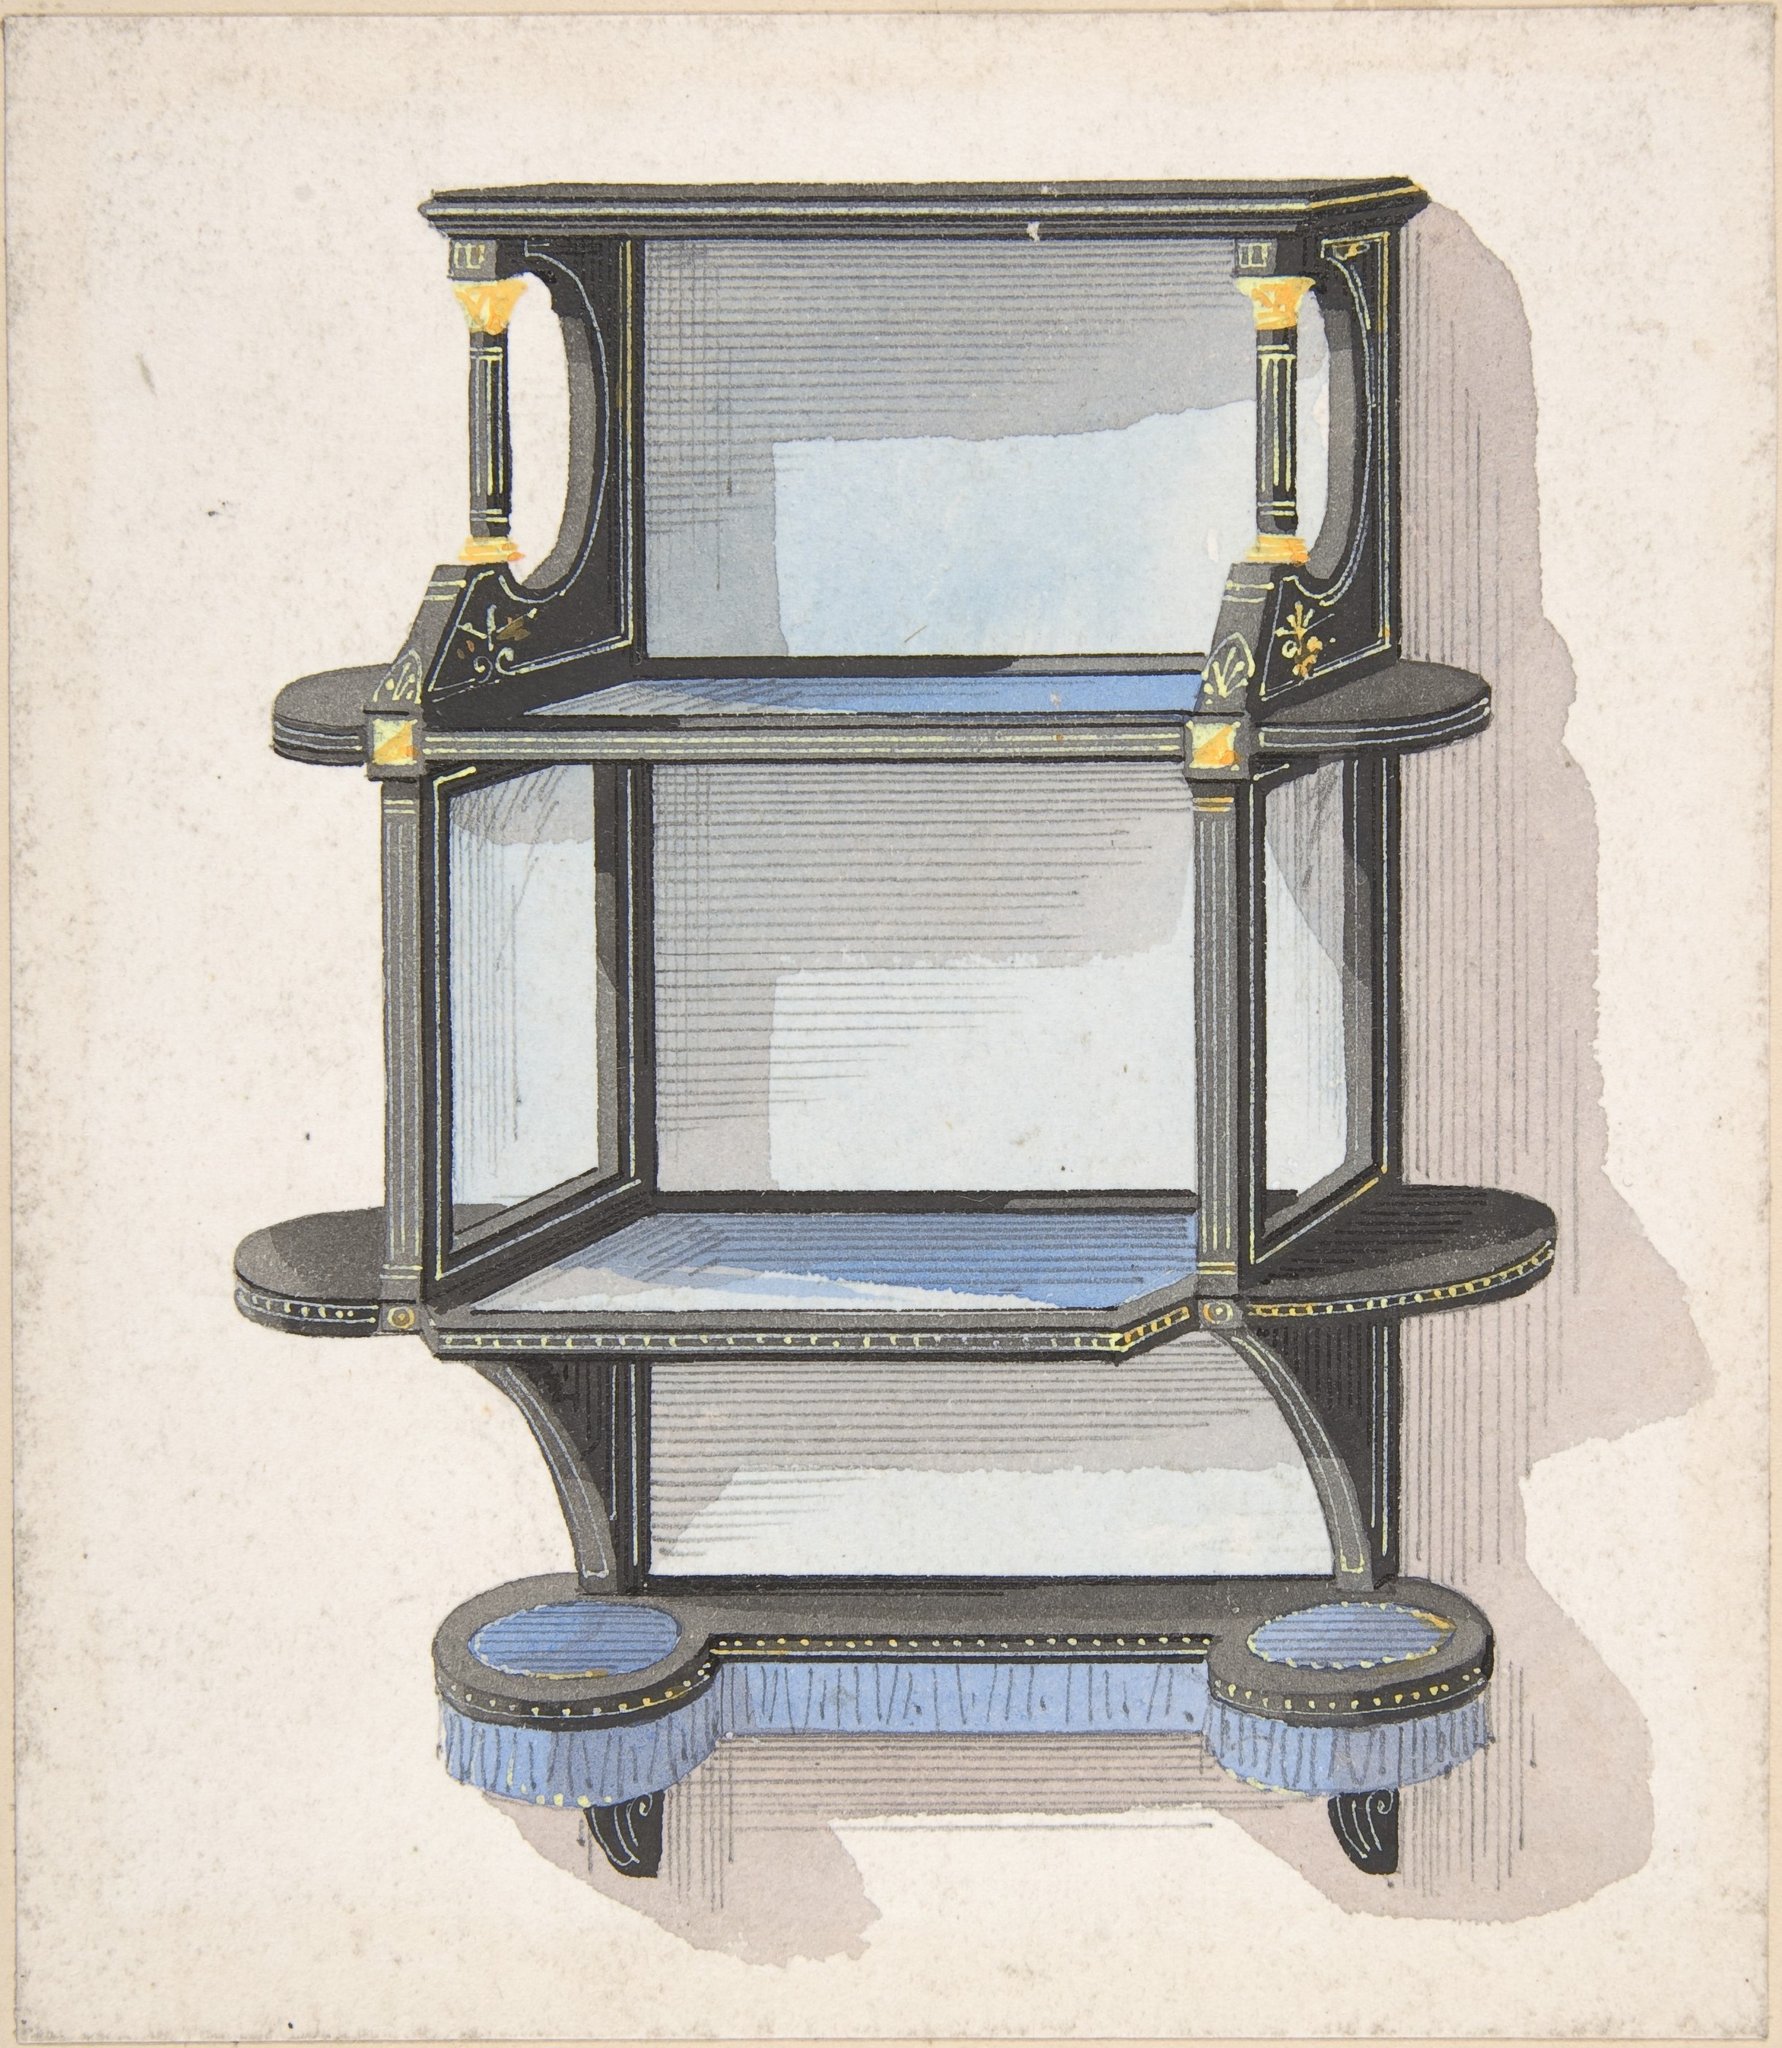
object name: drawing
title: Design for Hanging Shelves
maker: anonymous, british, 19th century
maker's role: artist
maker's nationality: british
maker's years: 1800-1900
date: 1840-1899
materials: gouache, ink, watercolor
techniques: pen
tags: furniture